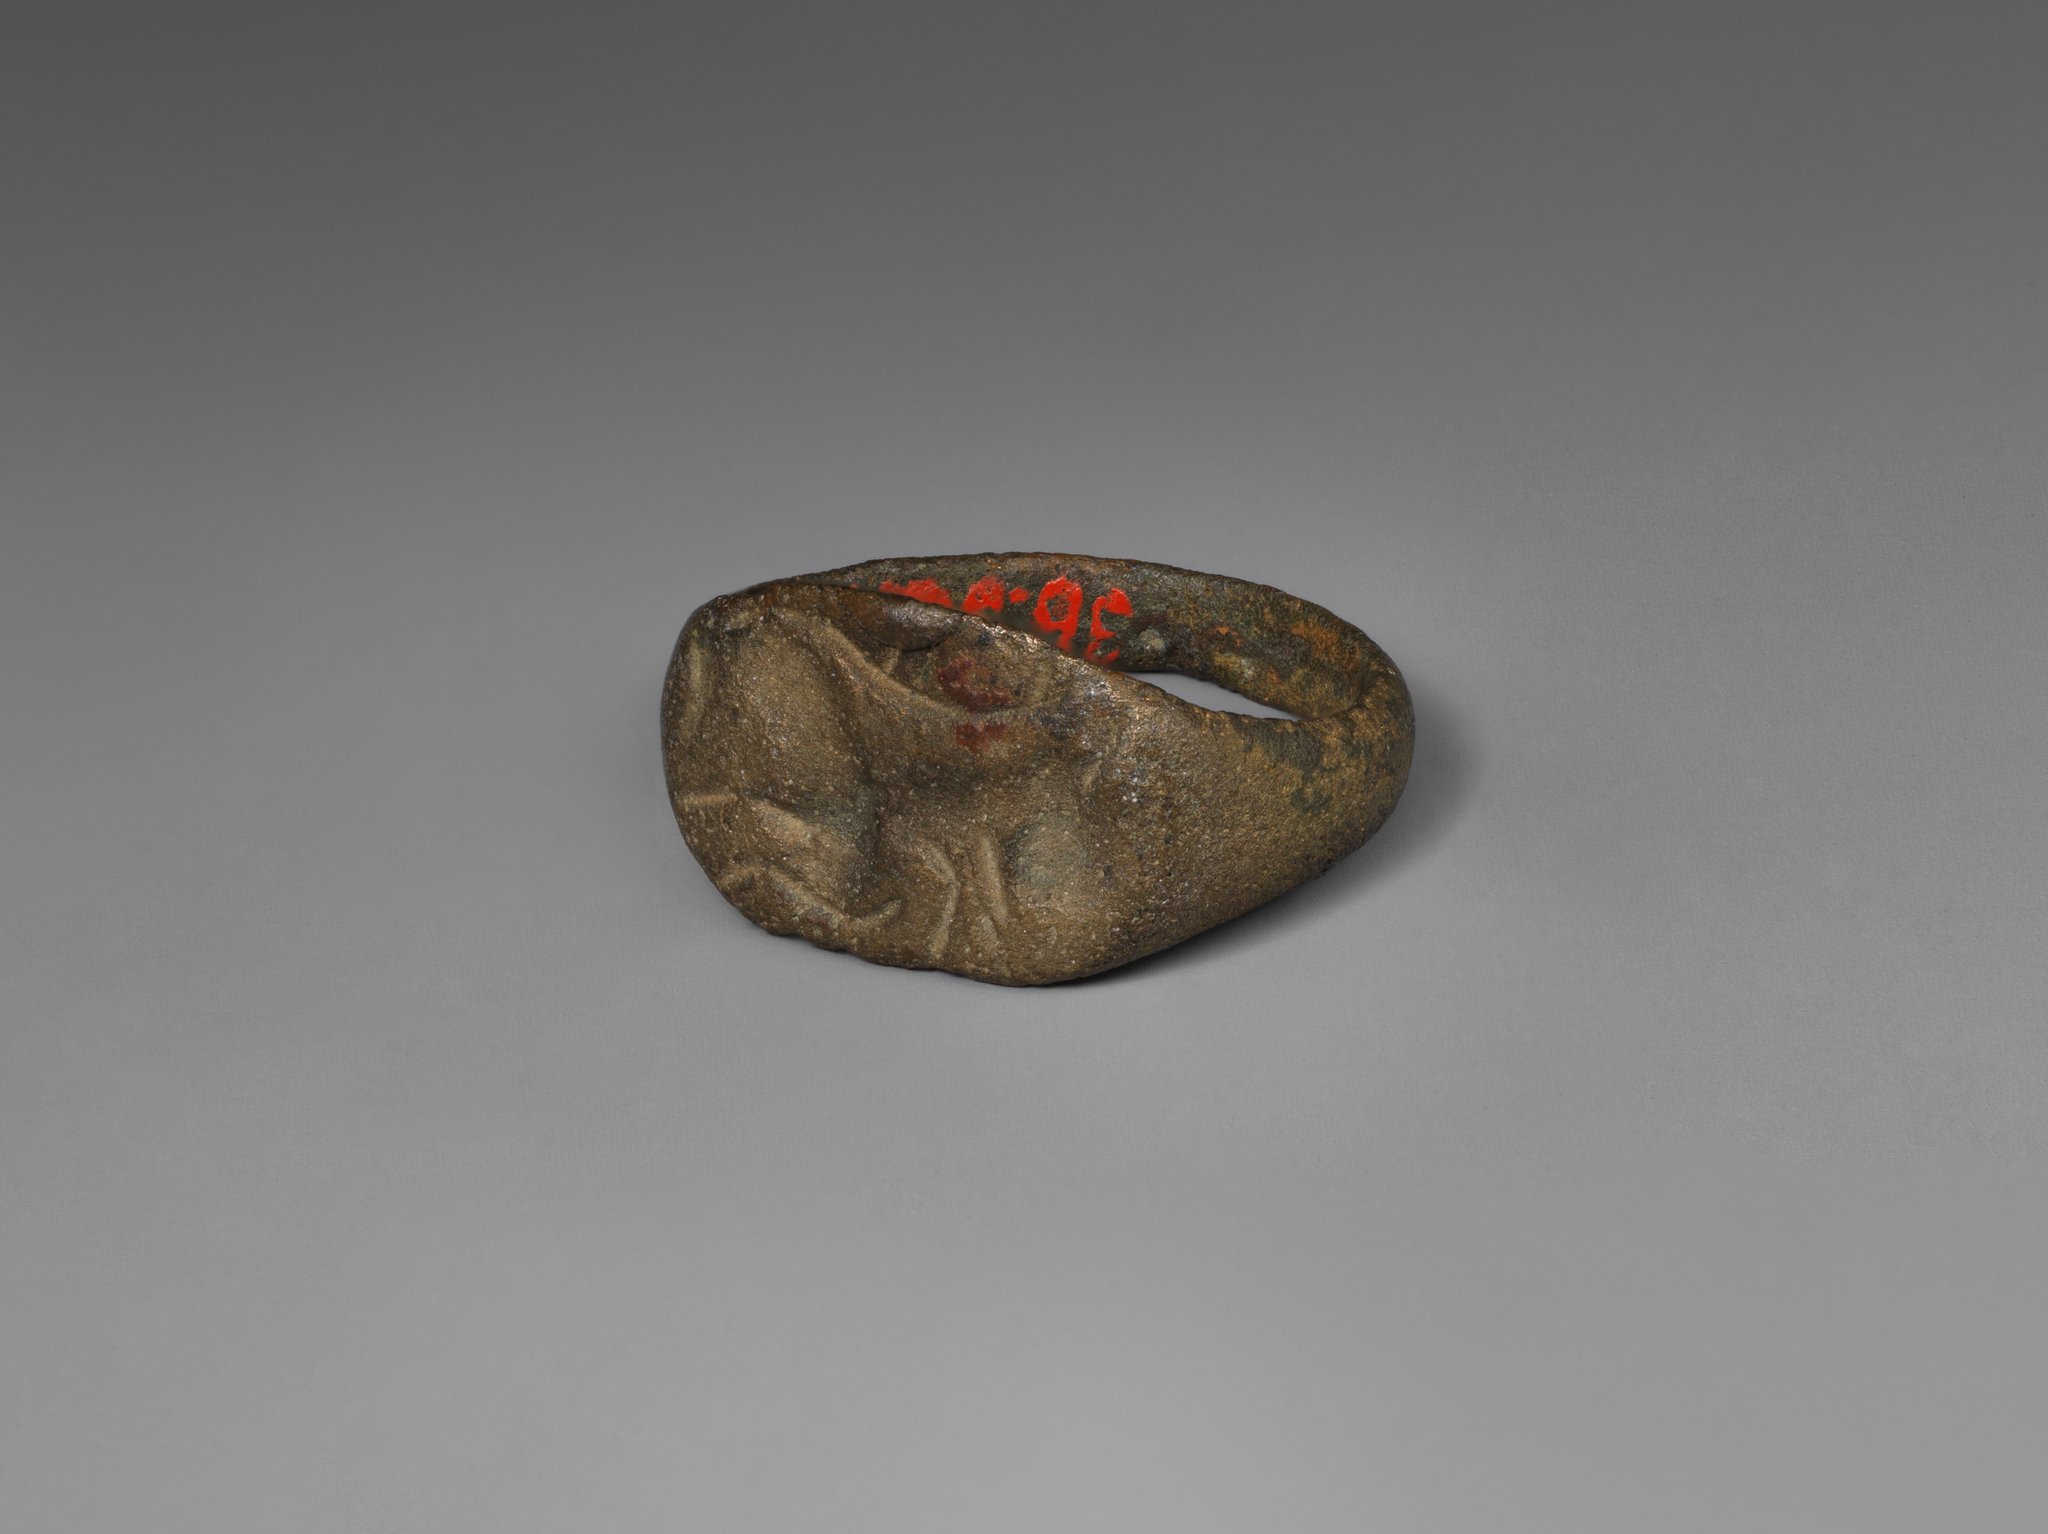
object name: ring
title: Finger ring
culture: sasanian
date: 201-700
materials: bronze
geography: iran